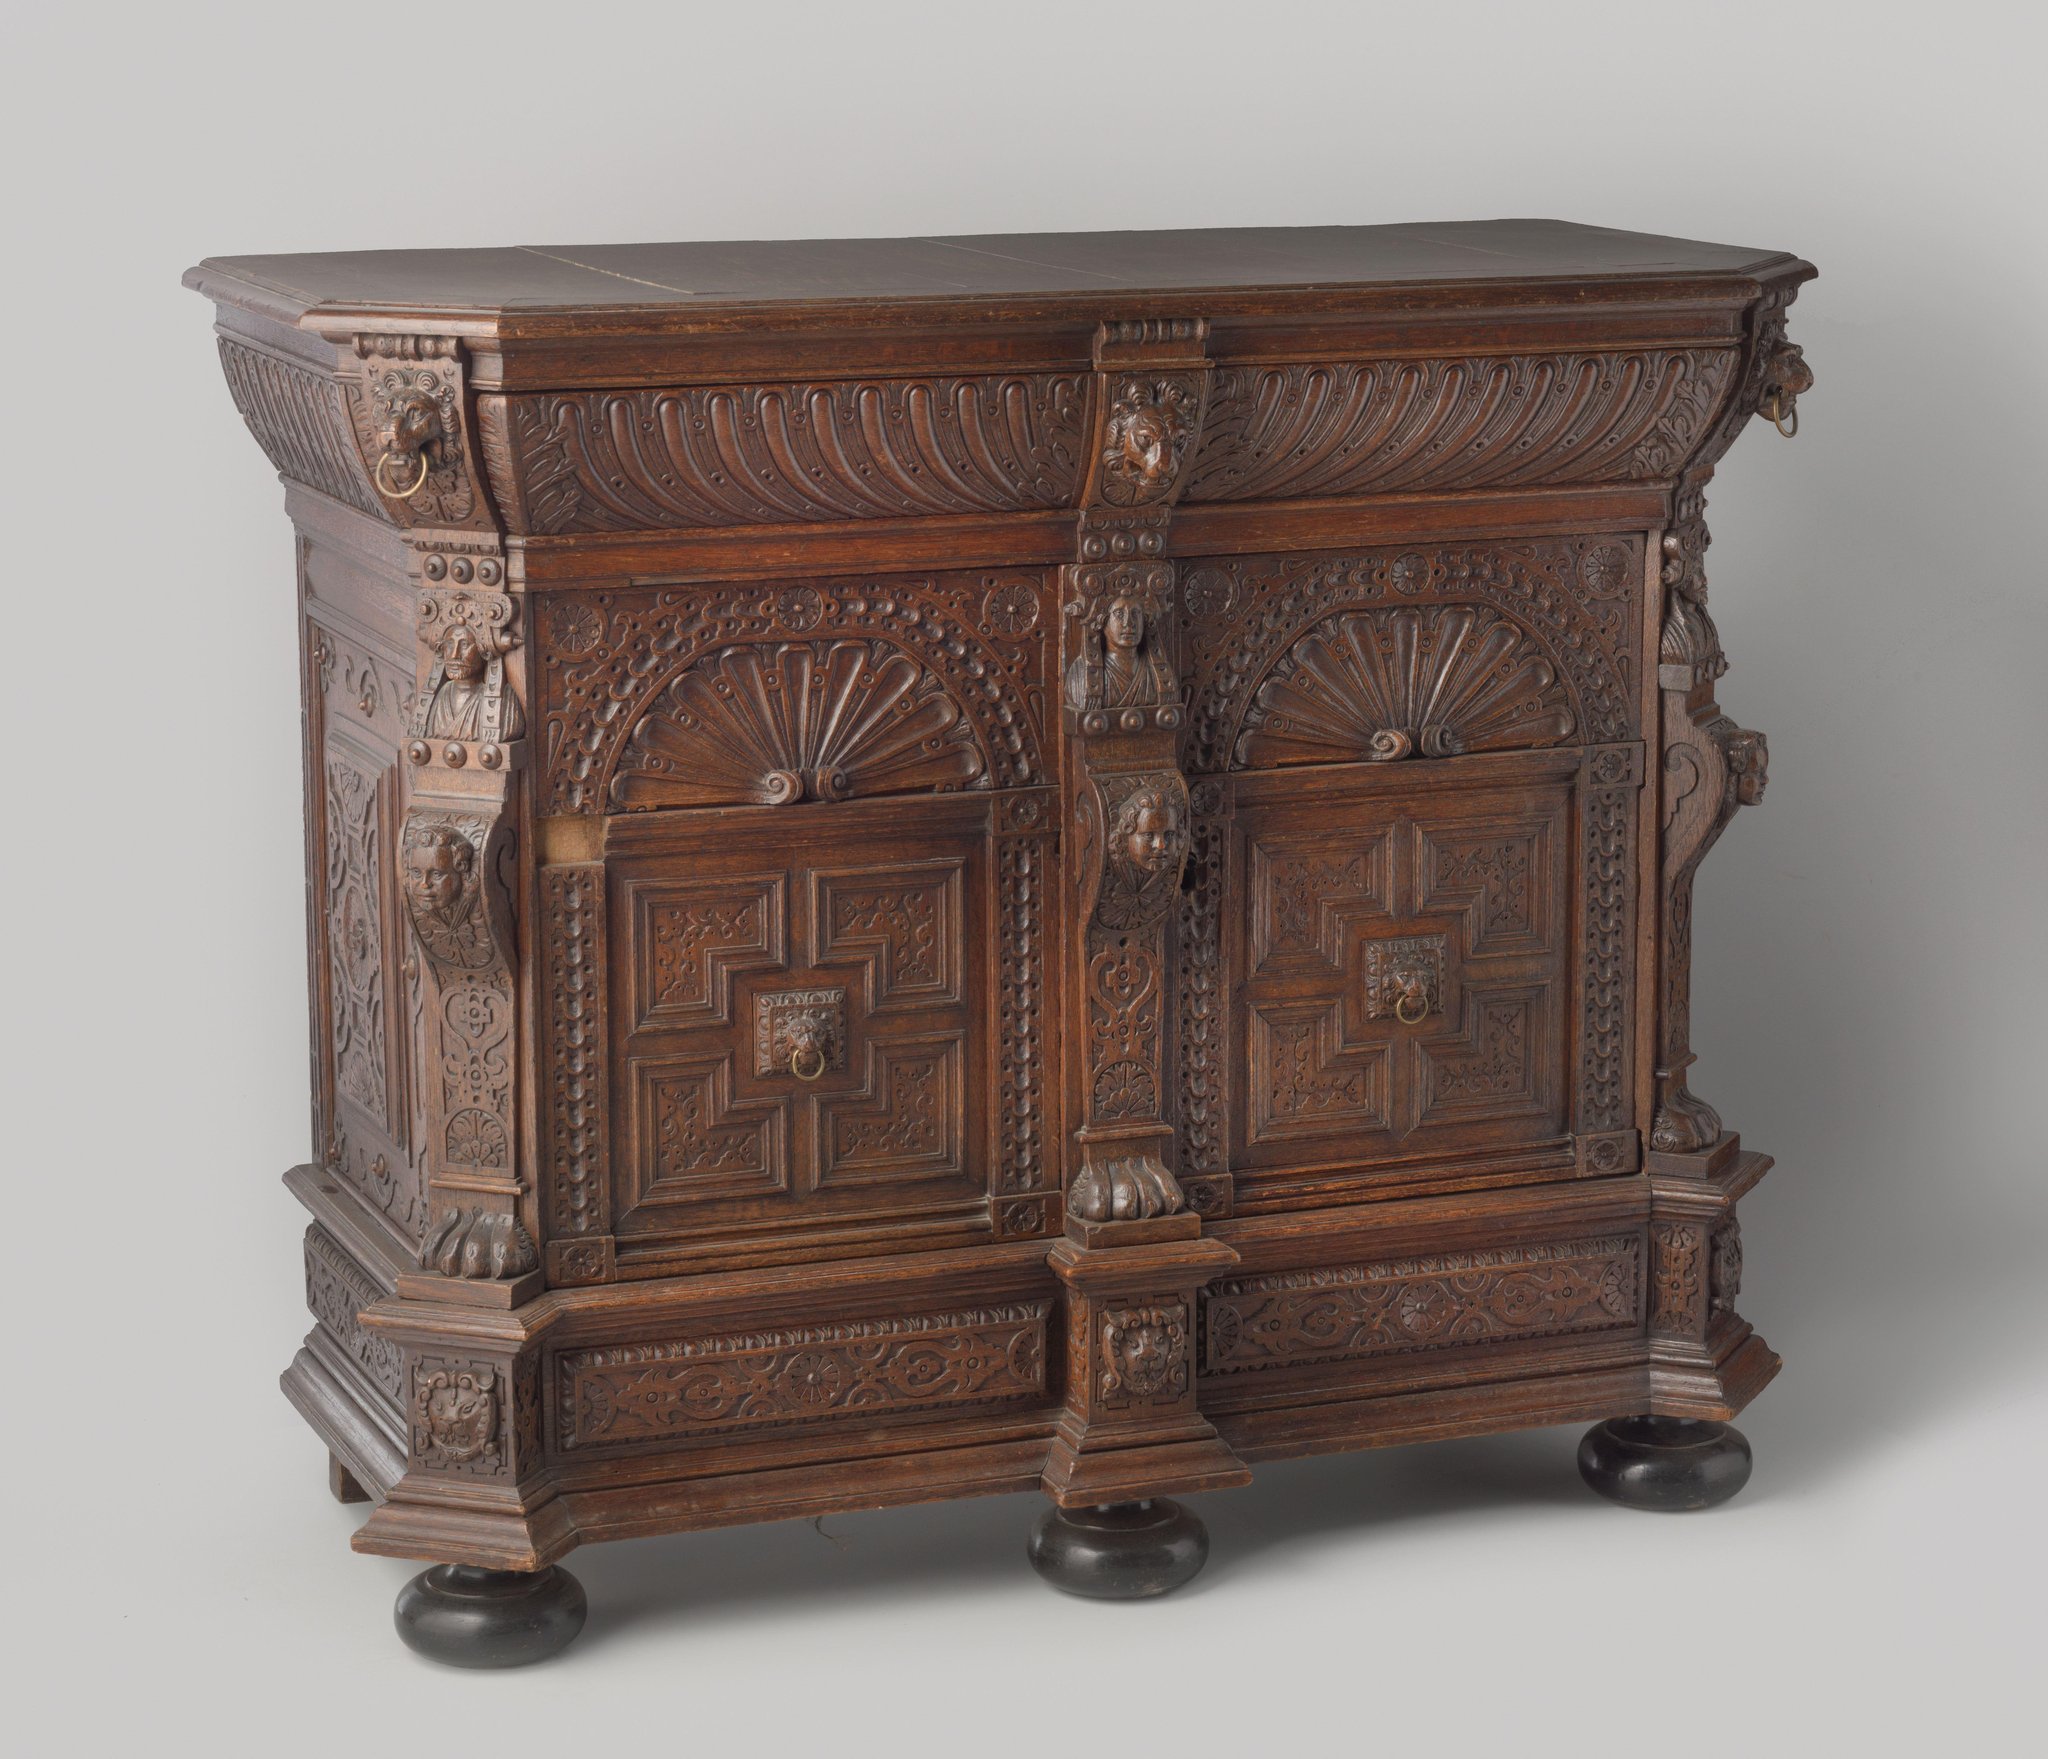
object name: buffet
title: Buffet met twee deuren met schelpvormige boogvulling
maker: Anonymous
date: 1620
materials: wood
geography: southern netherlands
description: Eikenhouten buffetkast met twee deuren die schelpvormige boogvullingen en corniswerk rondom een leeuwekop vertonen. Op de middenstijl en de overhoeks geplaatste hoekstijlen zijn hermkariatiden op beugelconsoles aangebracht, versierd met rolwerk en een vrouwenkopje en onderaan eindigend in een dierenklauw. De rechte plintlijst met rolwerk en de kwartronde fries met afgewende blaasknorren vertonen in het midden en op de hoeken verkroppingen, onderaan met dierenmaskers en bovenaan met leeuwekoppen met ring.